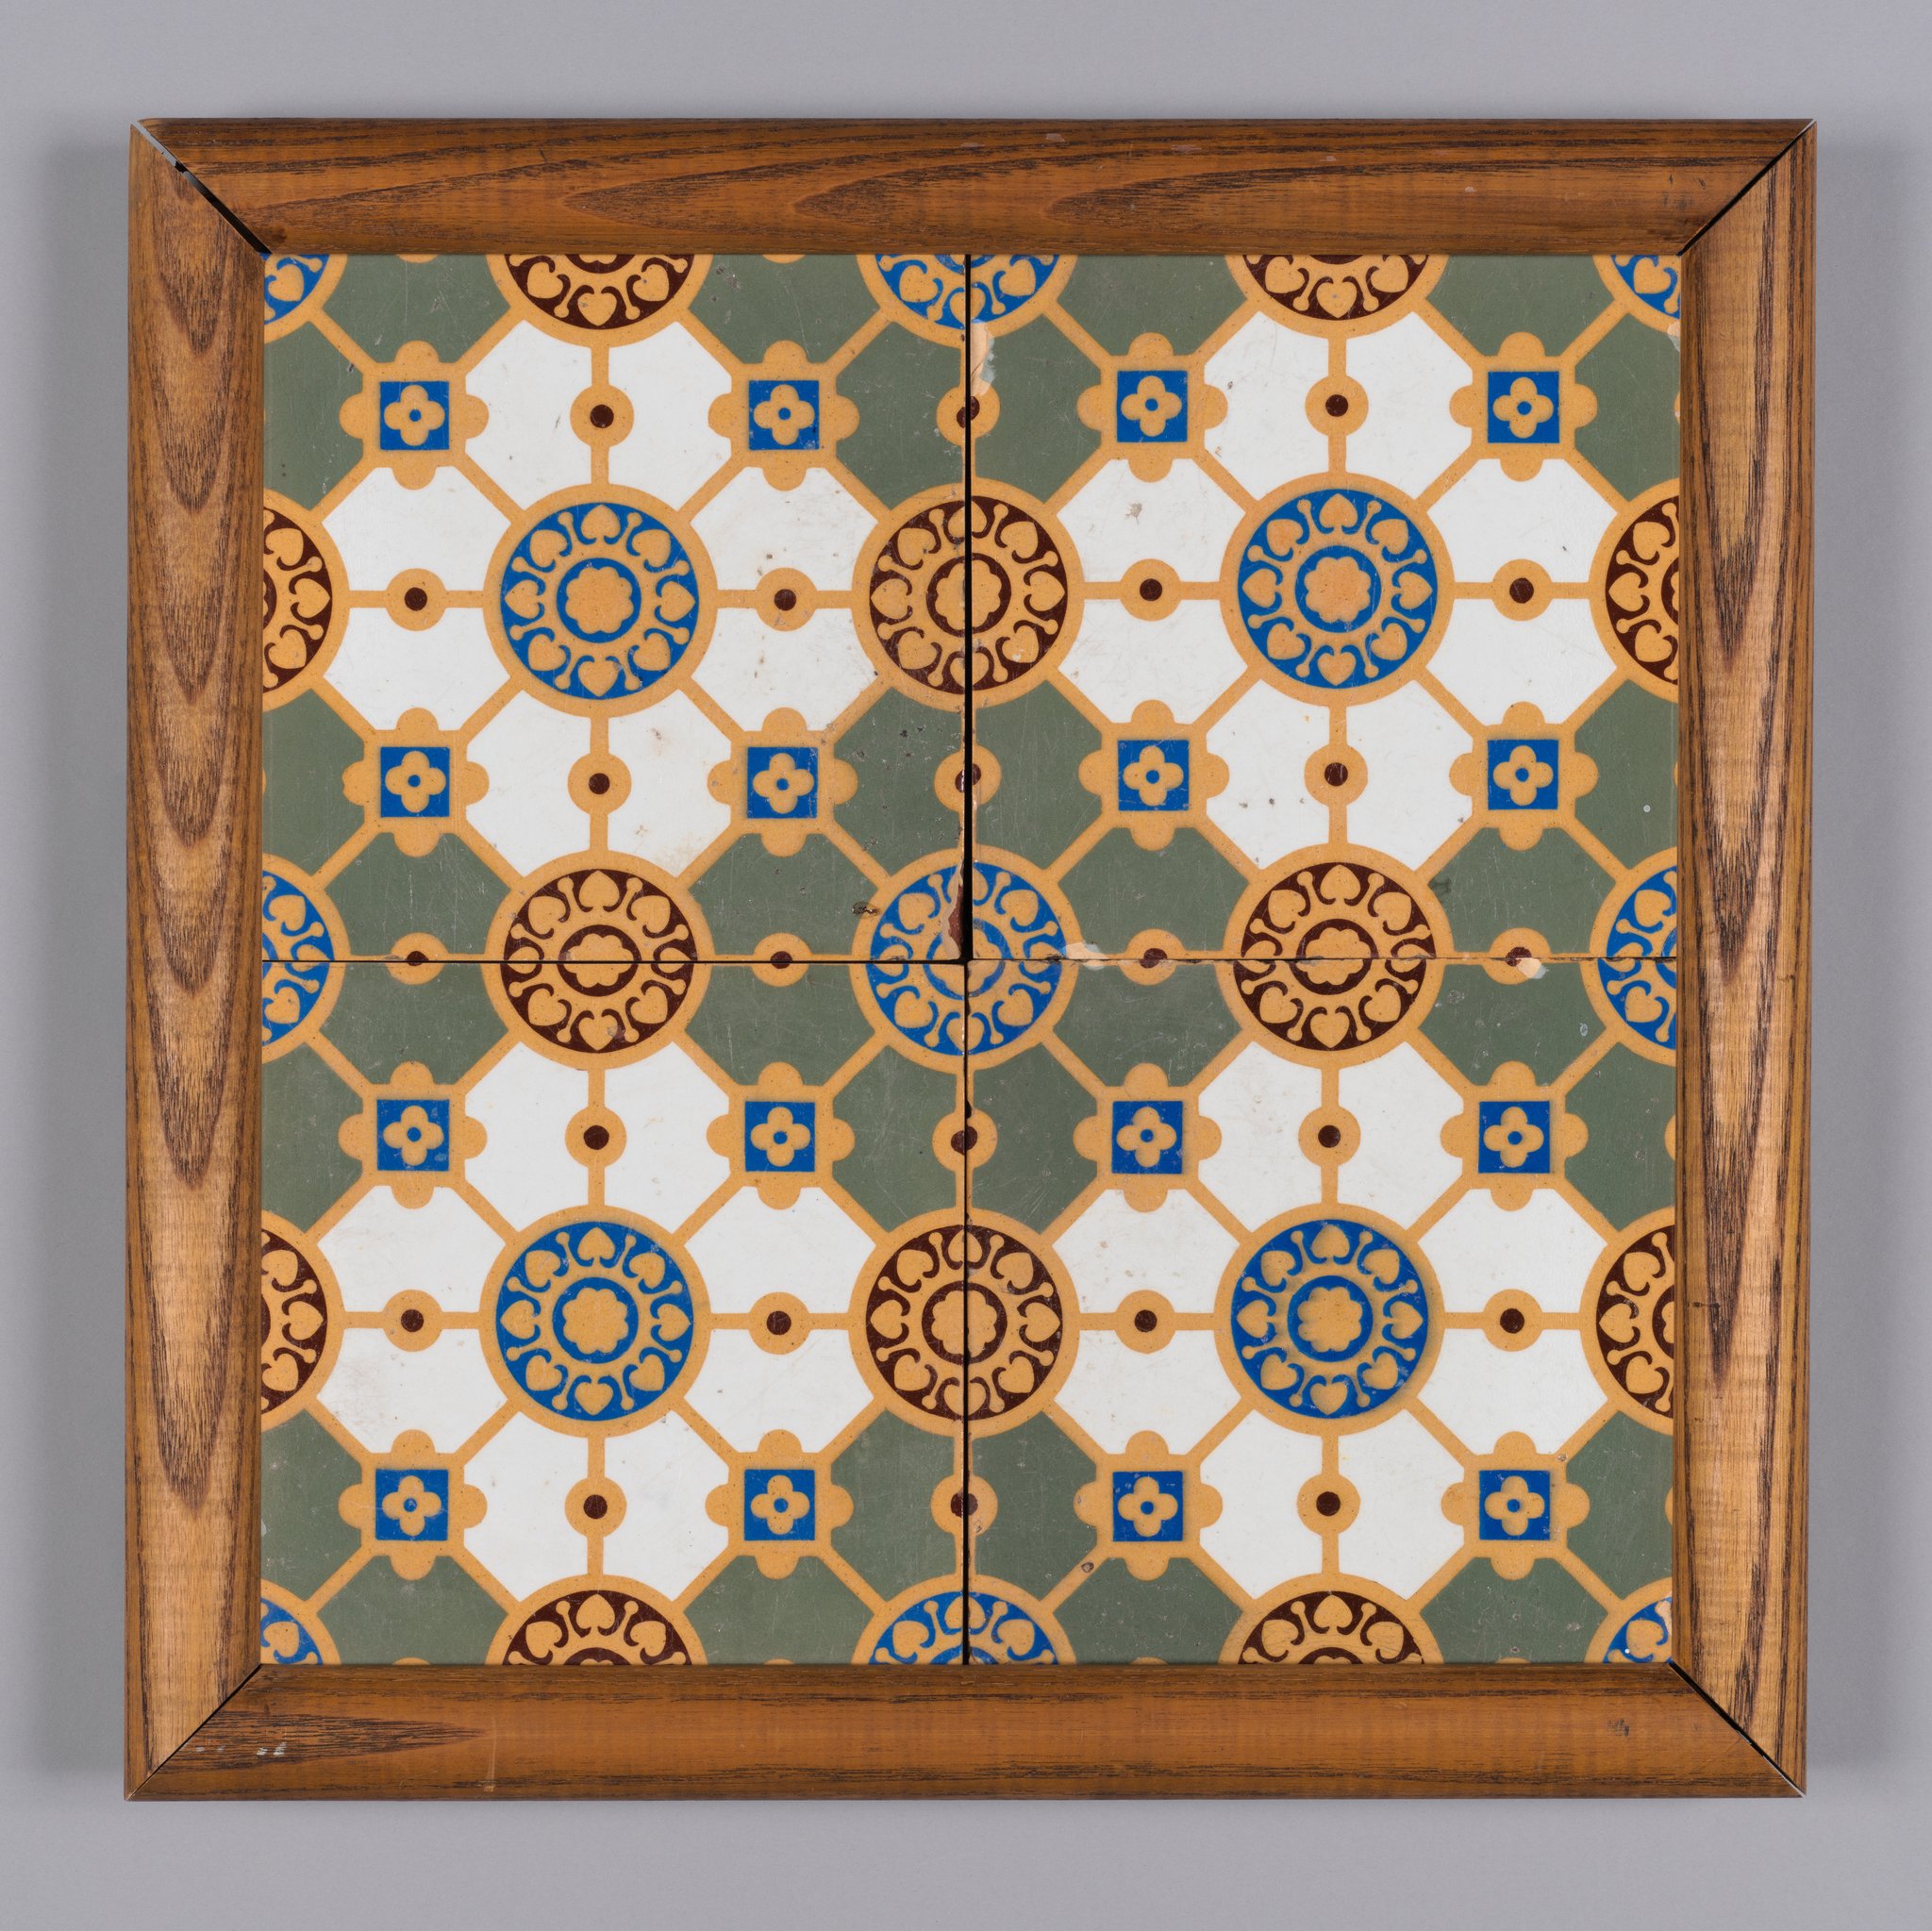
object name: tile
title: Panel of four tiles, framed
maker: christopher dresser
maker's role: designer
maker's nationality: british, scottish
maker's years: 1834-1904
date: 1880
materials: clay, earthenware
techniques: inlay